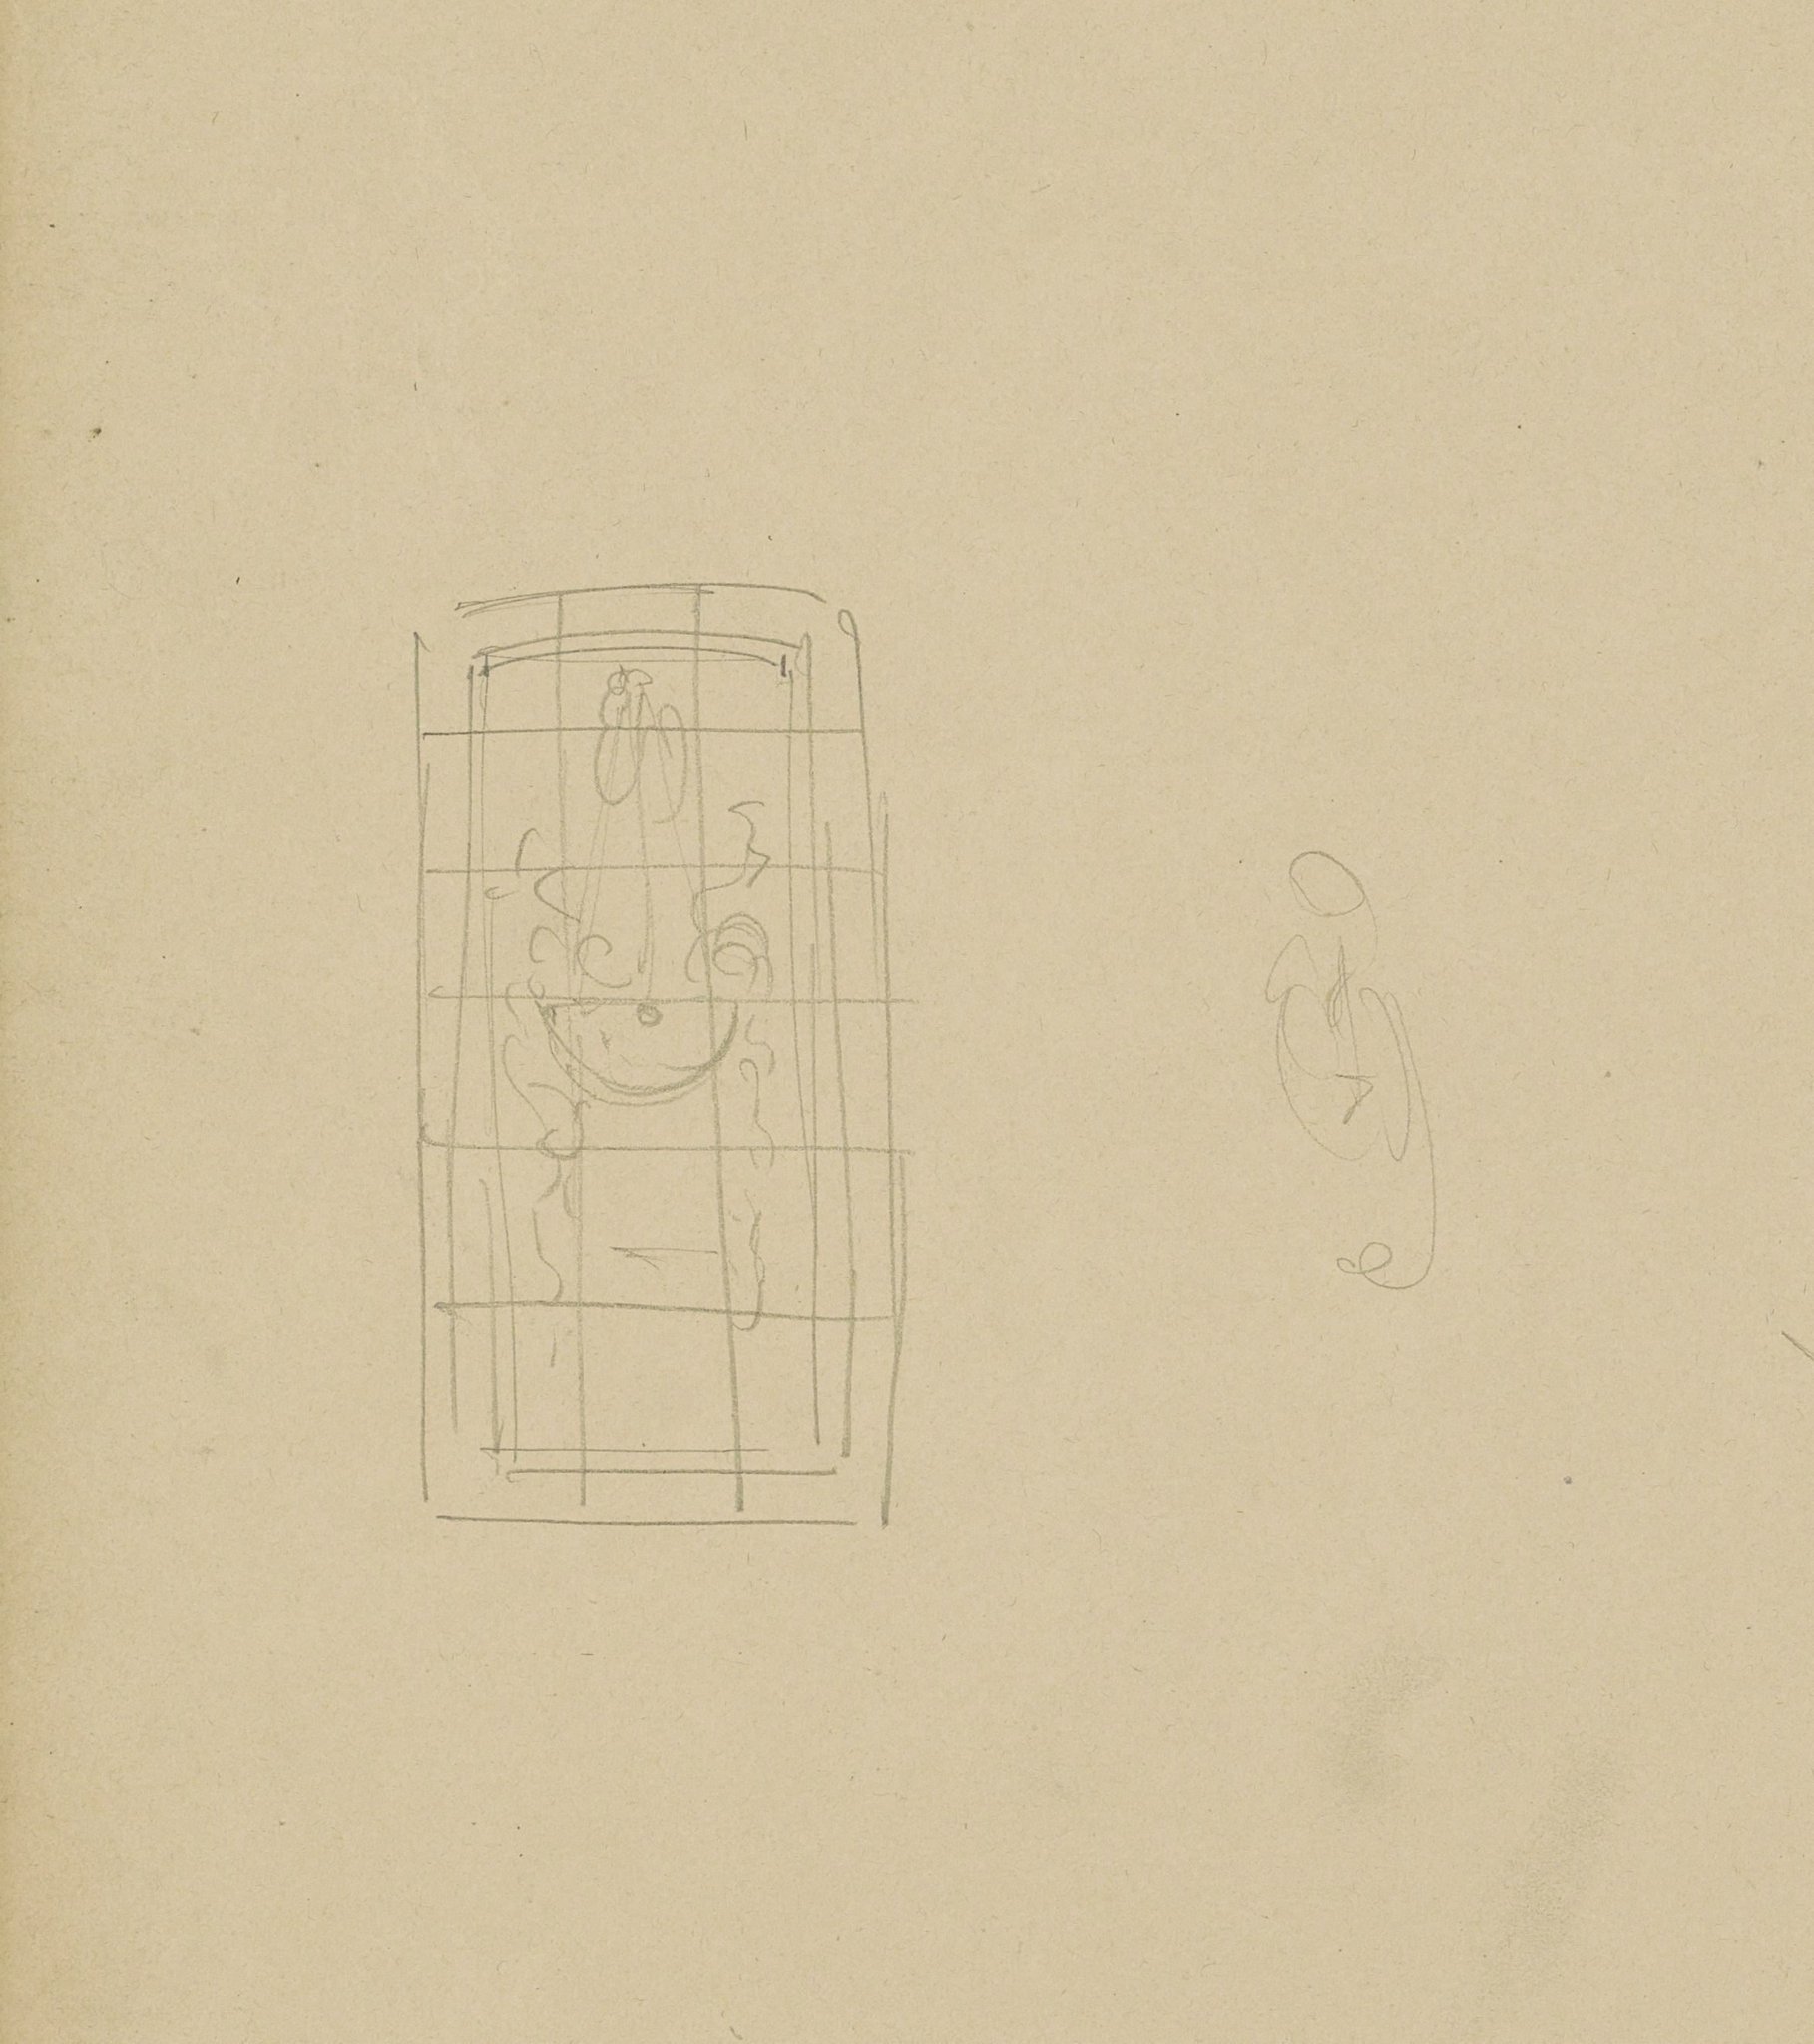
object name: sketchbook leaf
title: Kerkraam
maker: carel adolph lion cachet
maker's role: draughtsman, print maker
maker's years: 1864-1945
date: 1905-1906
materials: paper, pencil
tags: church-window, e.g. rose-window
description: Blad 25 verso uit een schetsboek met 30 bladen.